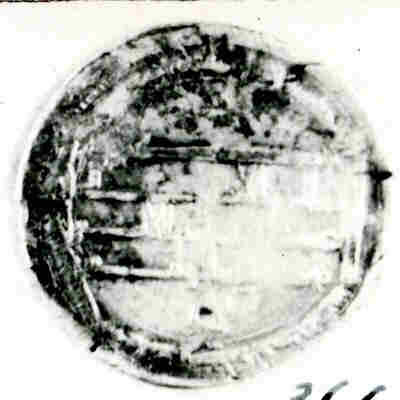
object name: coin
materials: silver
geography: balkh